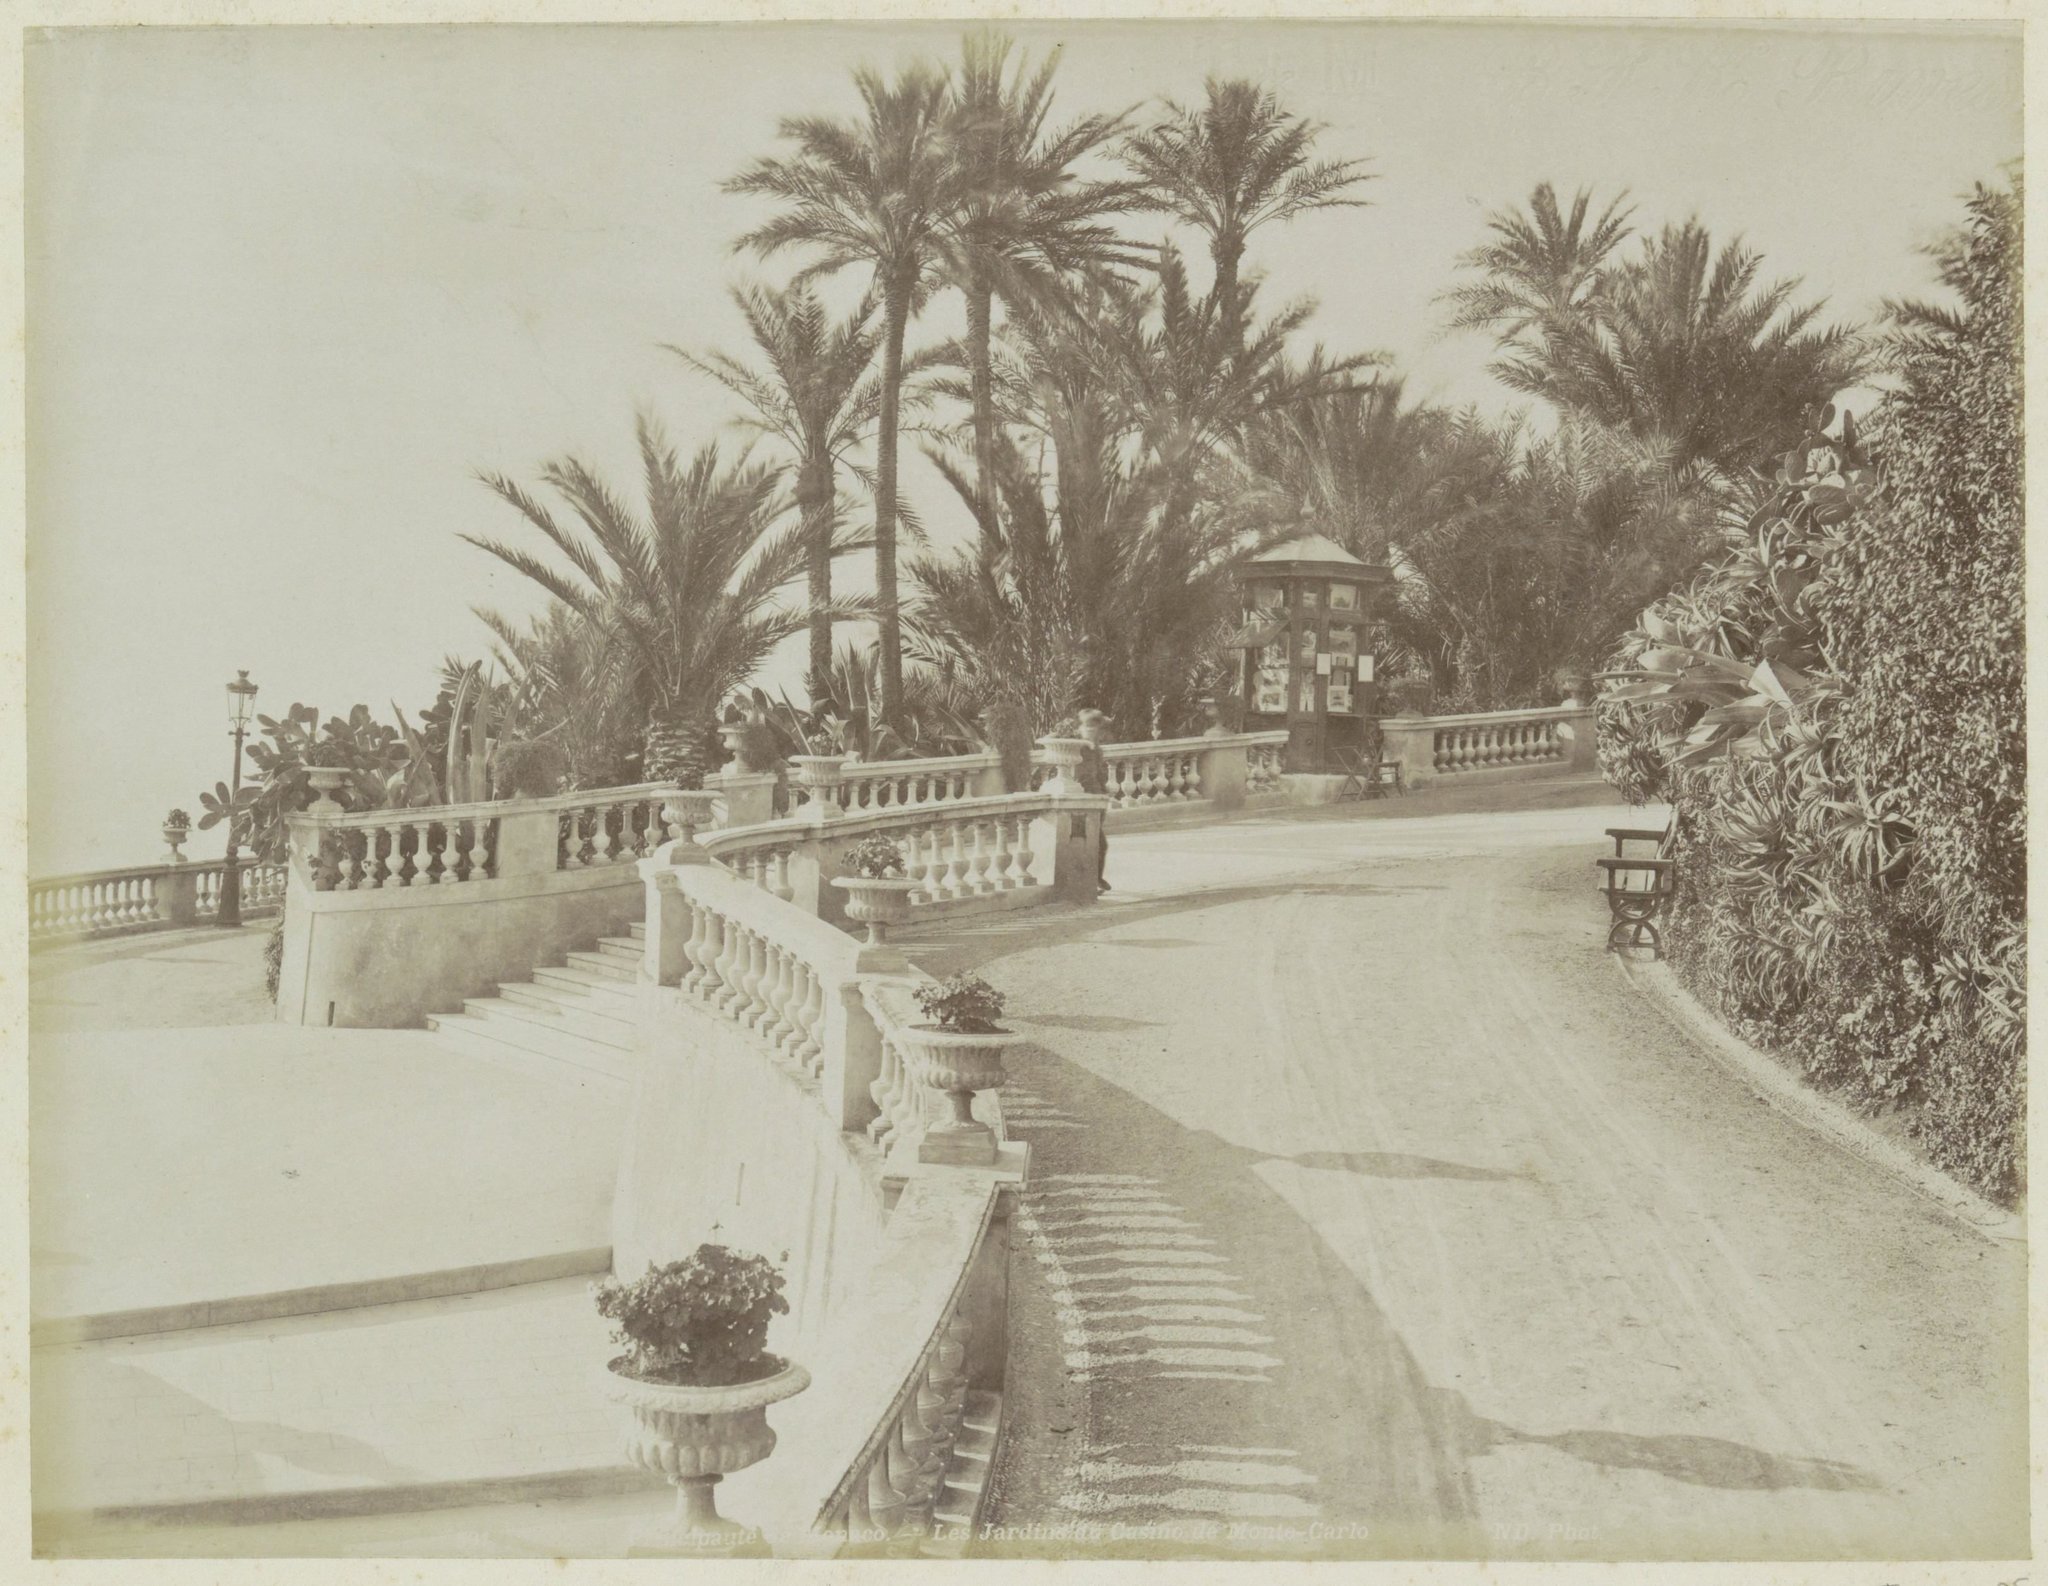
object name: photograph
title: Principauté de Monaco.- Les Jardins du Casino de Monte-Carlo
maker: étienne neurdein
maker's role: publisher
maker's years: 1832-1918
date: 1870-1900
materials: paper, photographic support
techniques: albumen print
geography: monaco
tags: casino, public gardens, park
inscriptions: negative number: ‘591’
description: Onderdeel van Reisalbum met foto's van bezienswaardigheden in Italië en Frankrijk.